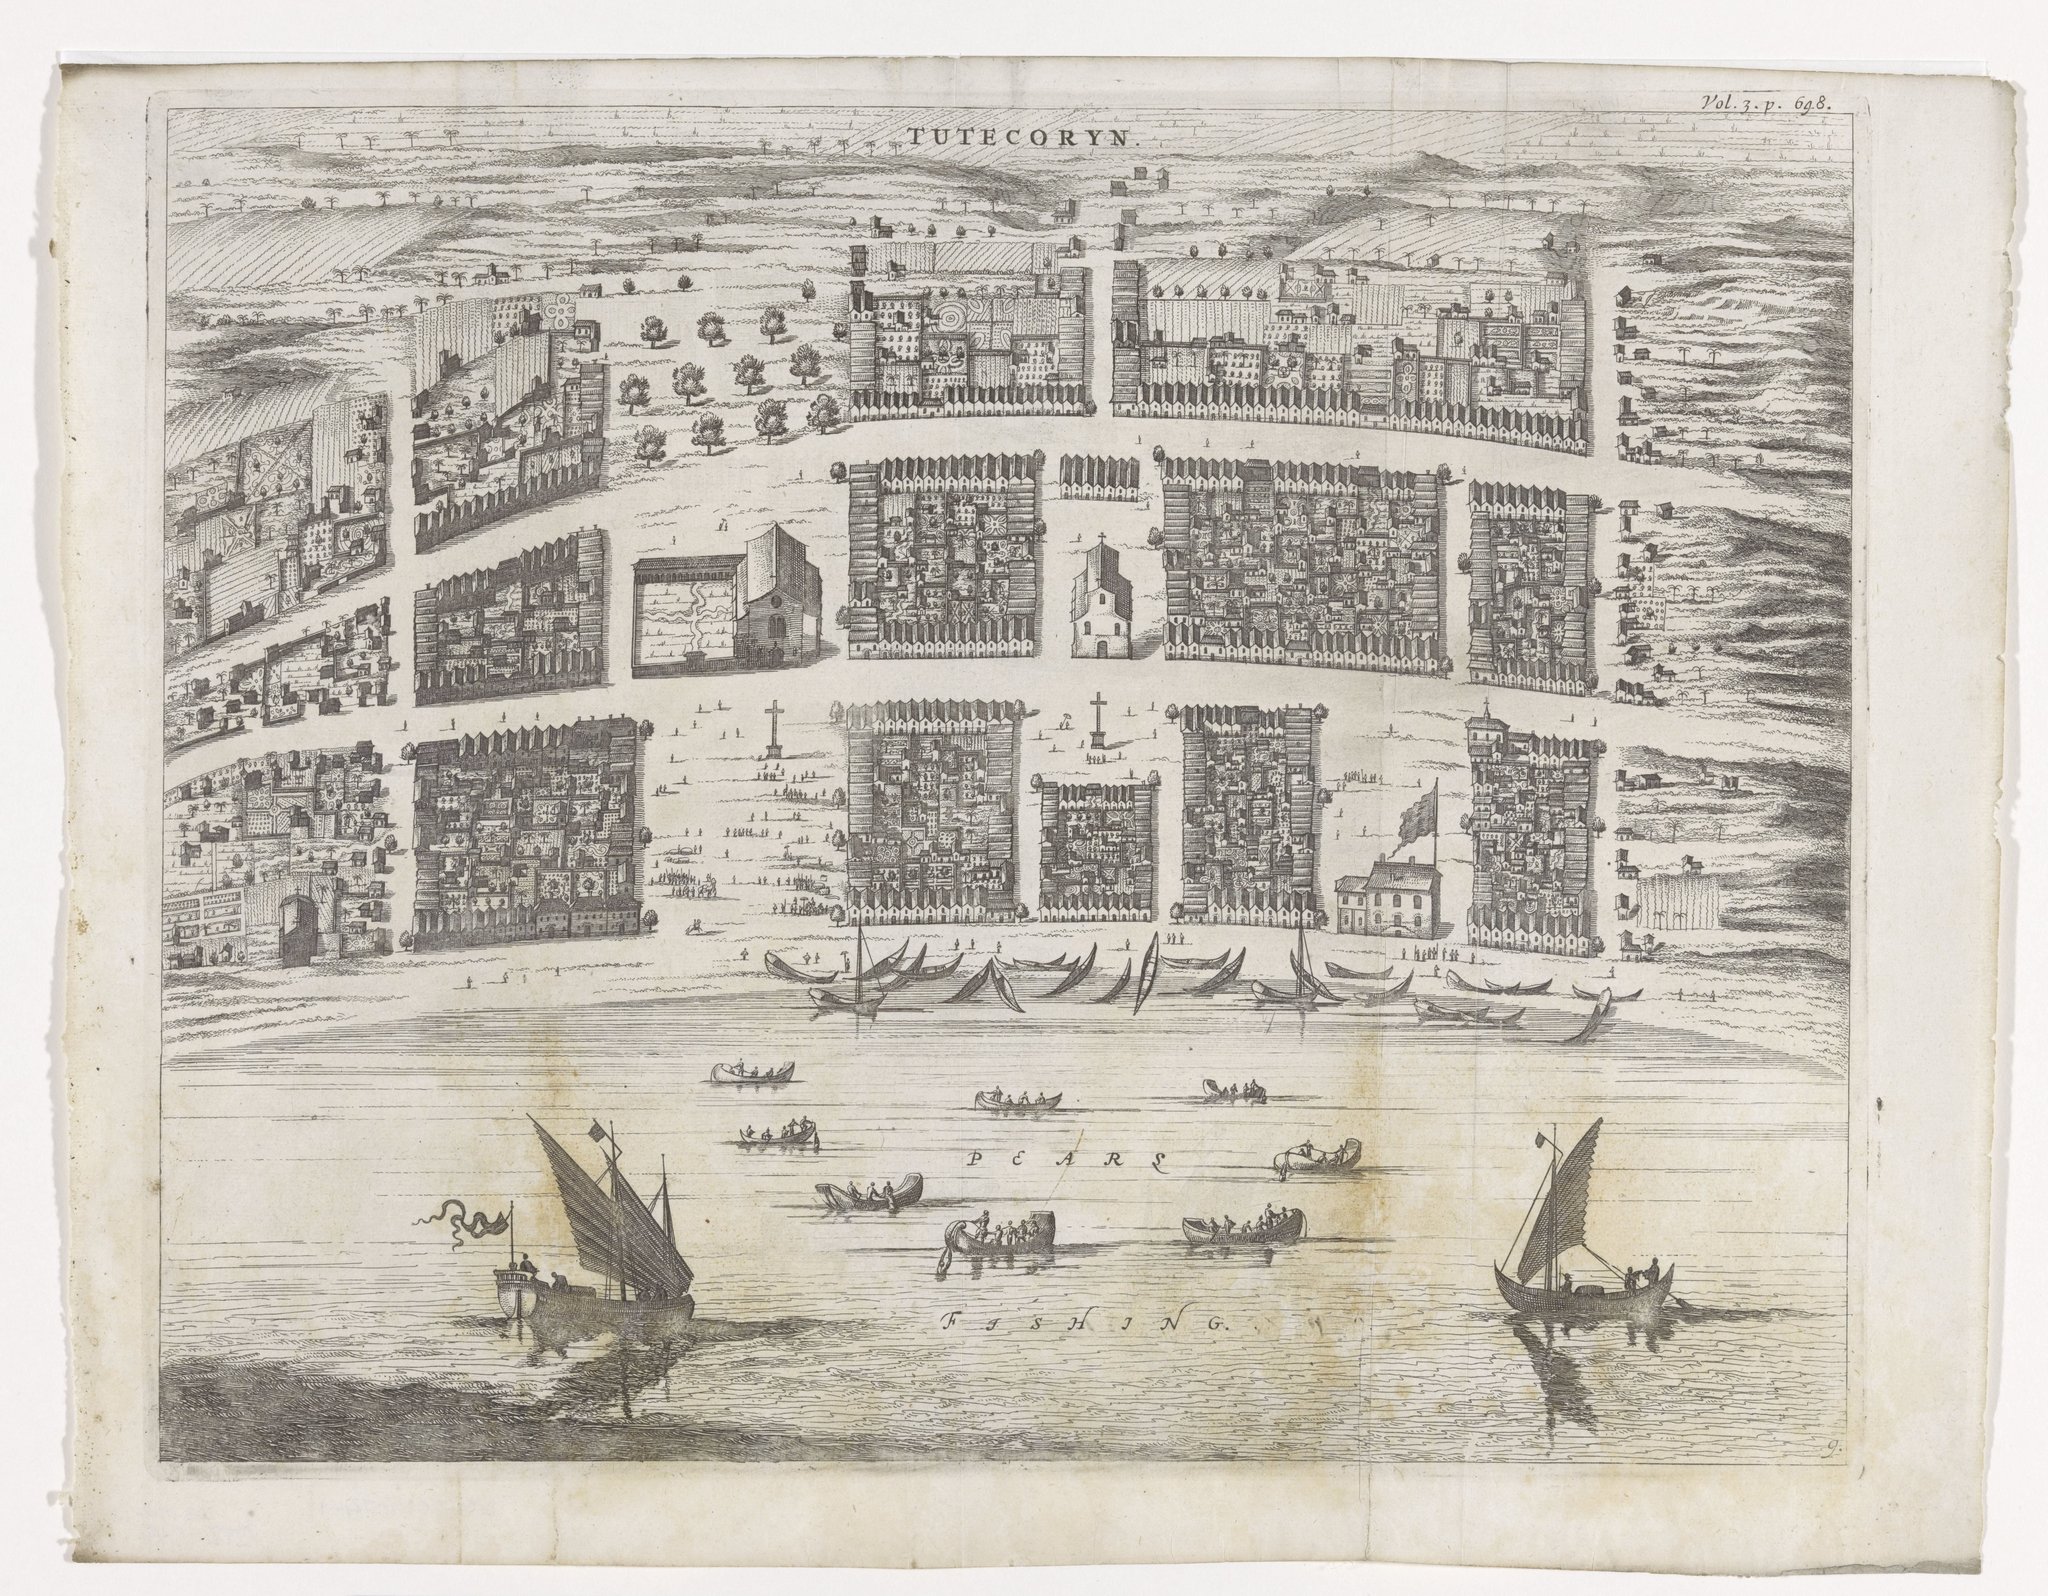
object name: print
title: Tutecoryn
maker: Anonymous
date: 1670-1672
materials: paper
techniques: etching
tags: verenigde oostindische compagnie, tuticorin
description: Gebruikt als illustratie in: Philippus Baldaeus, Naauwkeurige beschryvinge van Malabar en Choromandel Naauwkeurige beschryvinge van Malabar en Choromandel. Amsterdam 1672.